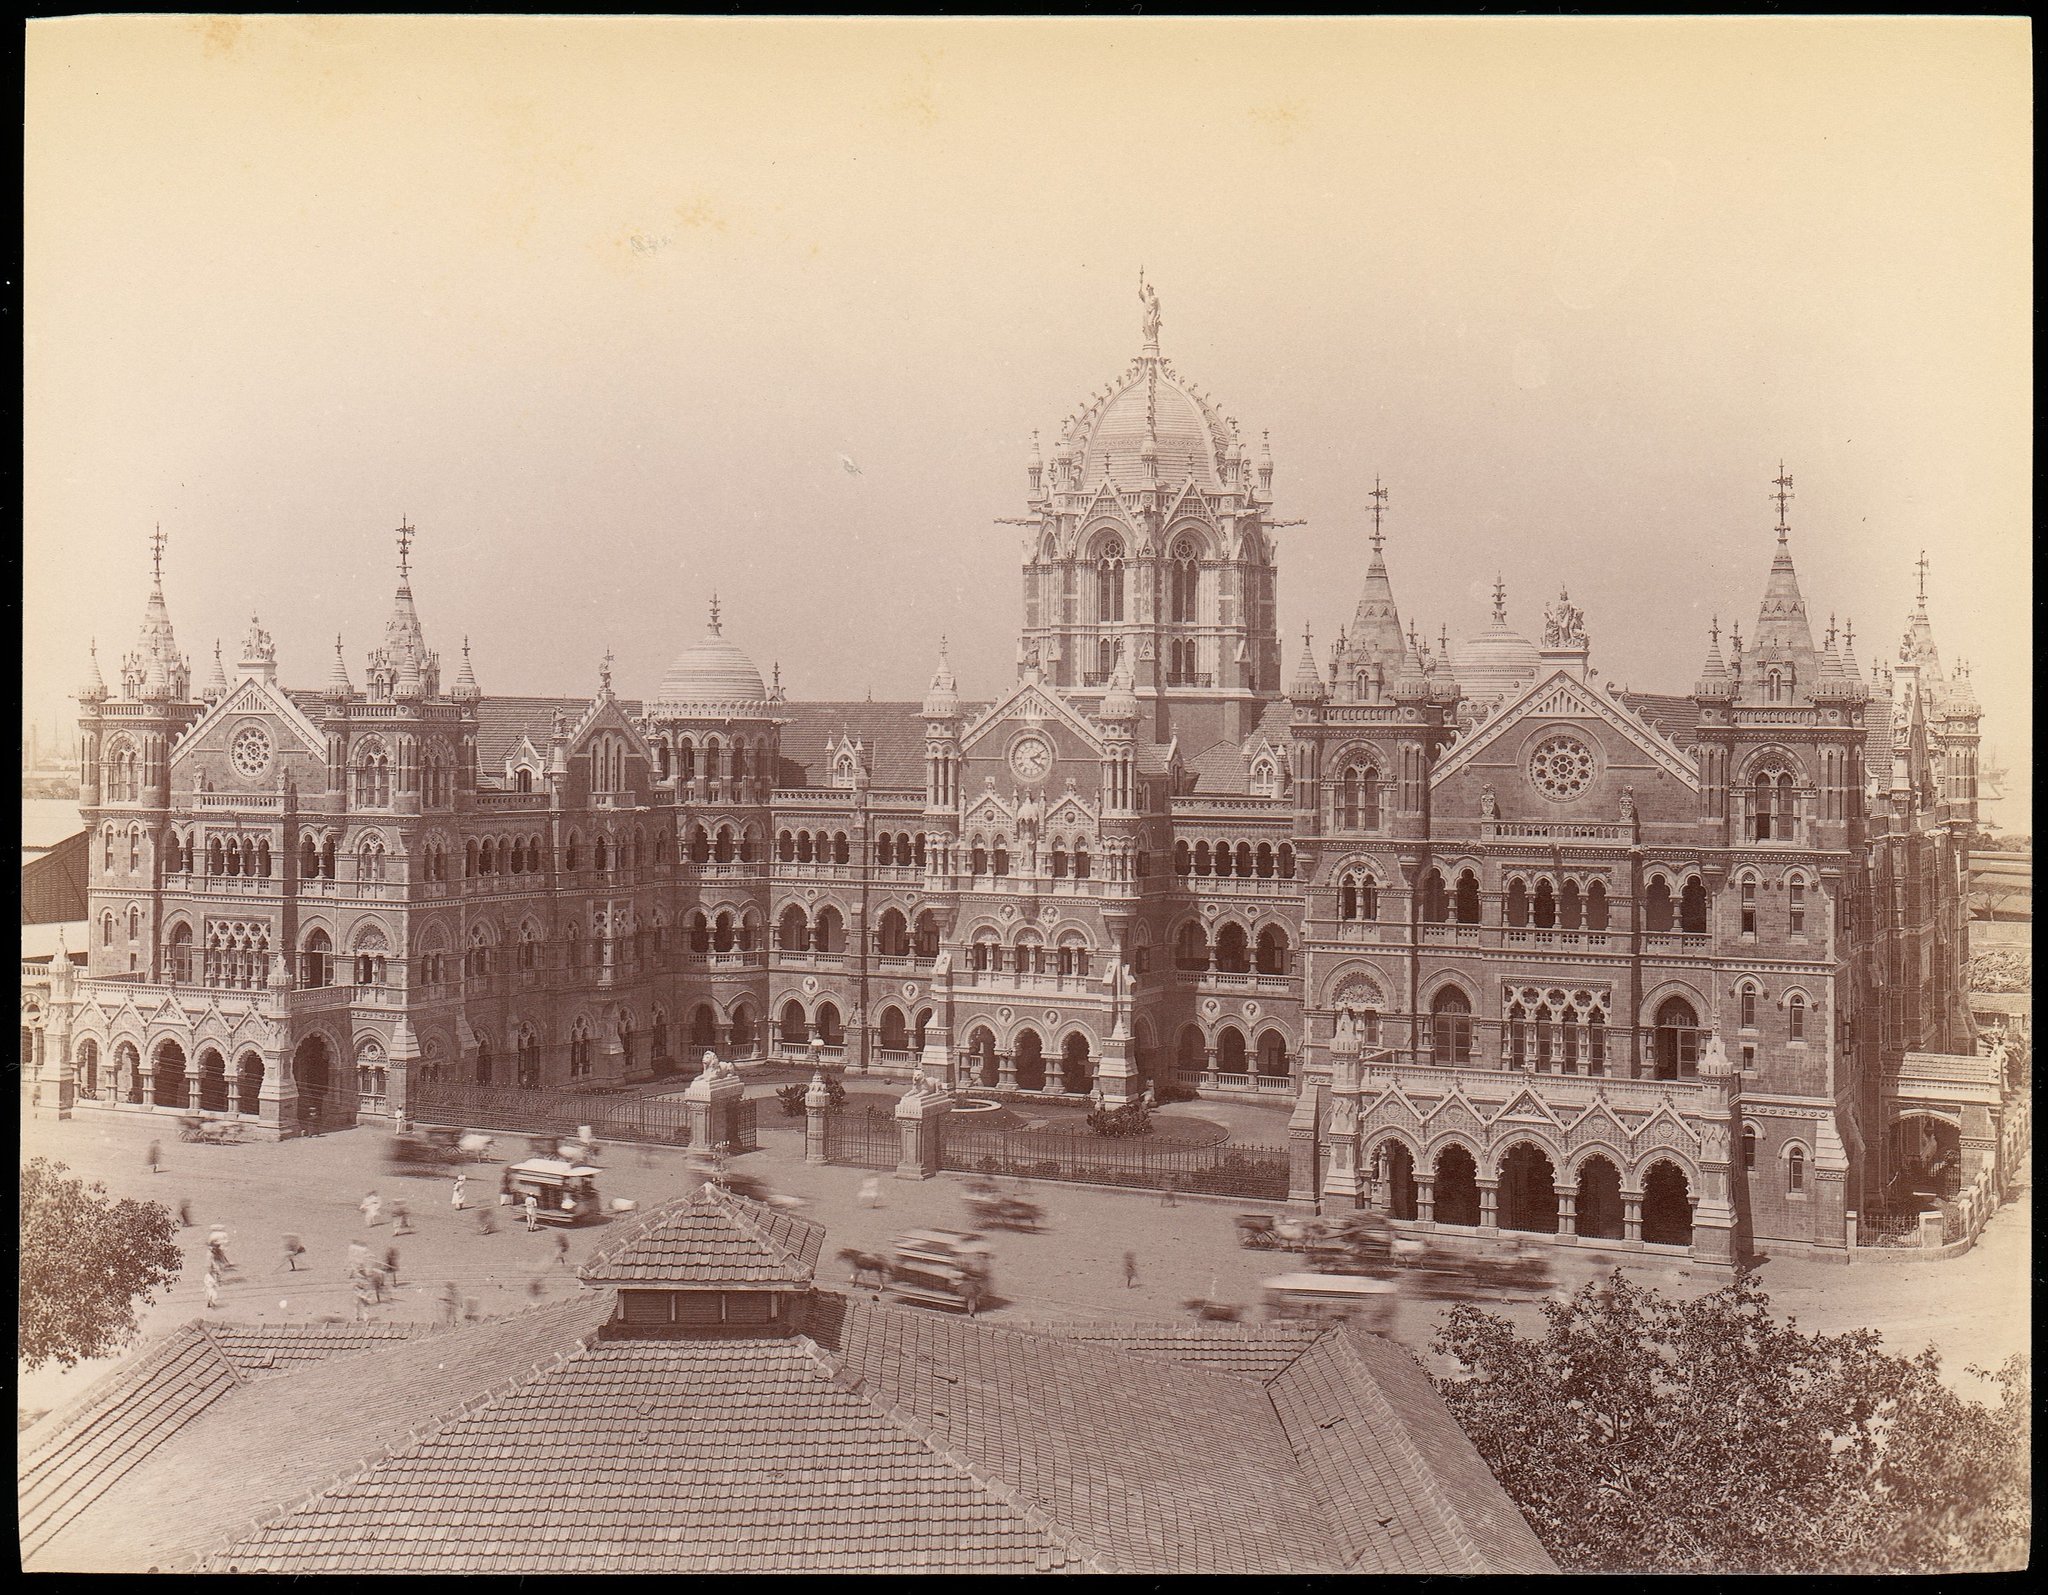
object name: photograph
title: [Victoria Terminus Building, Mumbai]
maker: Anonymous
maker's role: artist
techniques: albumen silver print, glass negative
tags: architecture,train stations